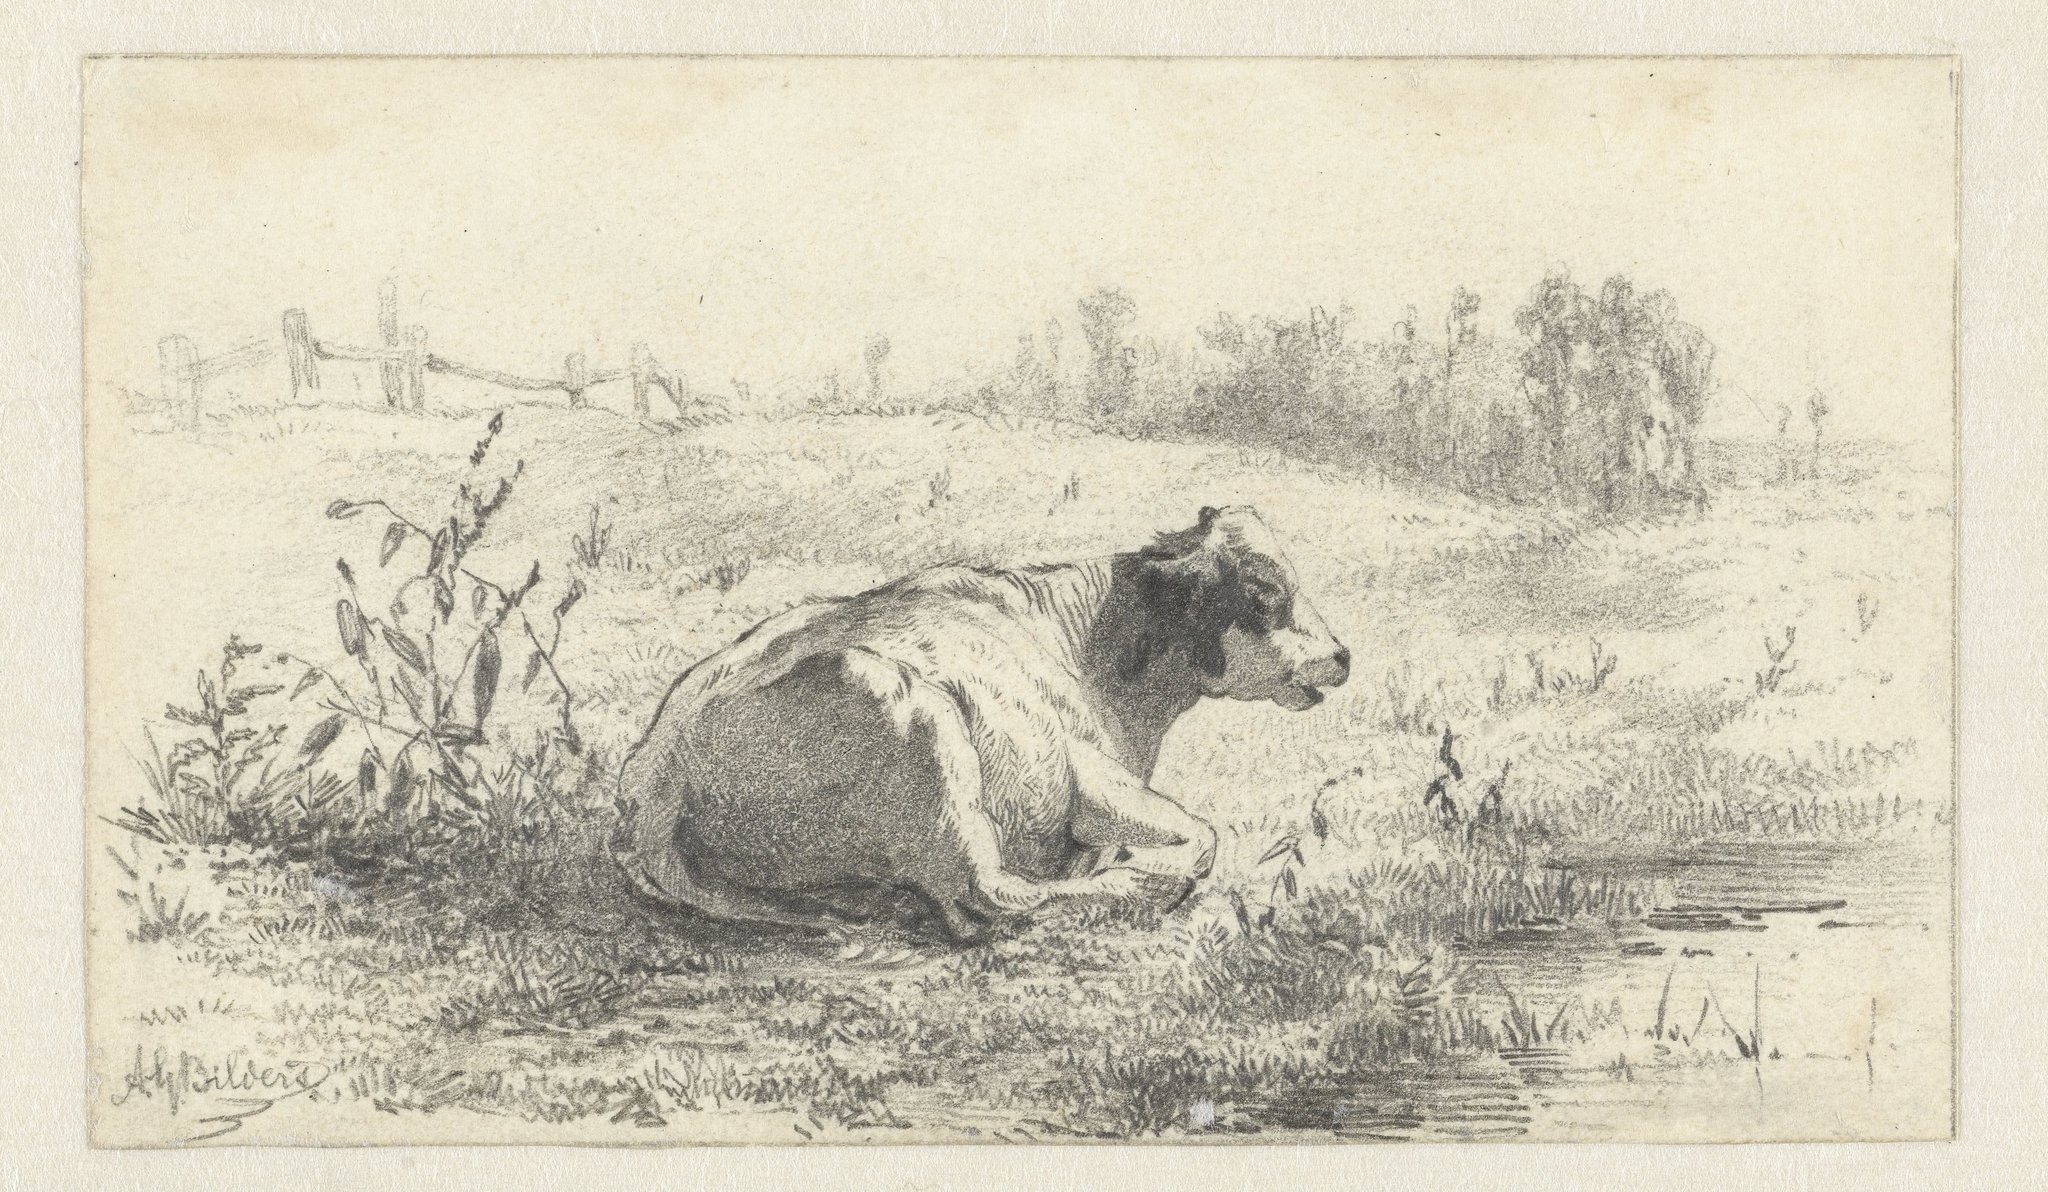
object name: drawing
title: Liggende koe in landschap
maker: gerard bilders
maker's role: draughtsman, print maker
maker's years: 1838-1865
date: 1848-1865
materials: paper, pencil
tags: cow